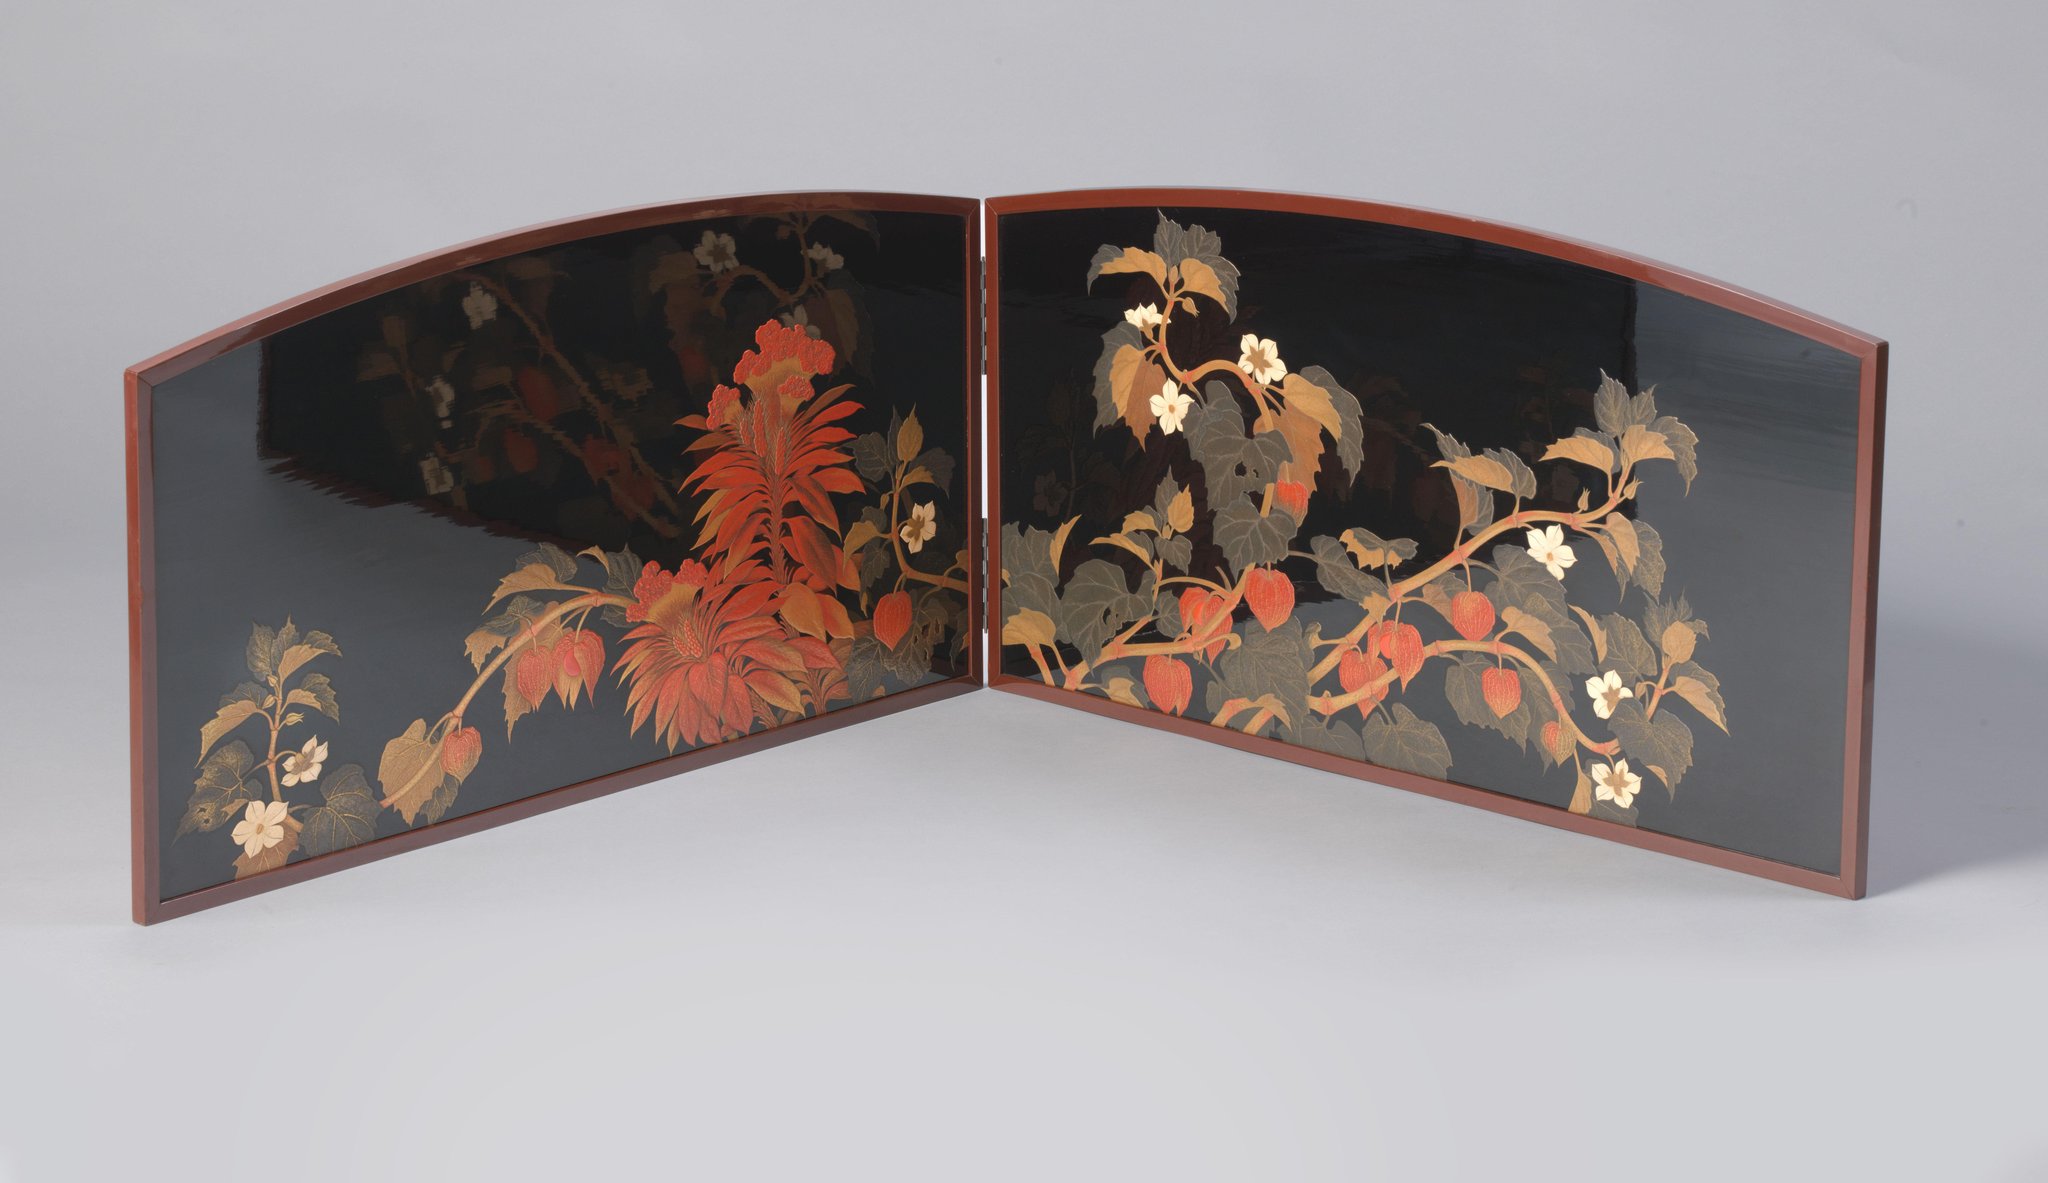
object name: vouwscherm, kamerscherm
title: Screen with Chinese lantern plant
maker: keishō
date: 1936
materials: lacquer, wood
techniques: lacquer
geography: japan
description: Een tweeslags kamerscherm met gebogen bovenkant en een bruin kader, met tegen een zwarte achtergrond een versiering in taka-age (laagsgewijs met penseel opgebrachte lak) en maki-e, van een vruchtdragende en bloeiende lampionplant die zich over beide panelen slingert, op het linkerpaneel doorkruist door een rechtop staande hanenkamplant. Originele houten opbergdoos (tomobako) met een uitneembaar voorpaneel met twee ijzeren handvaten.